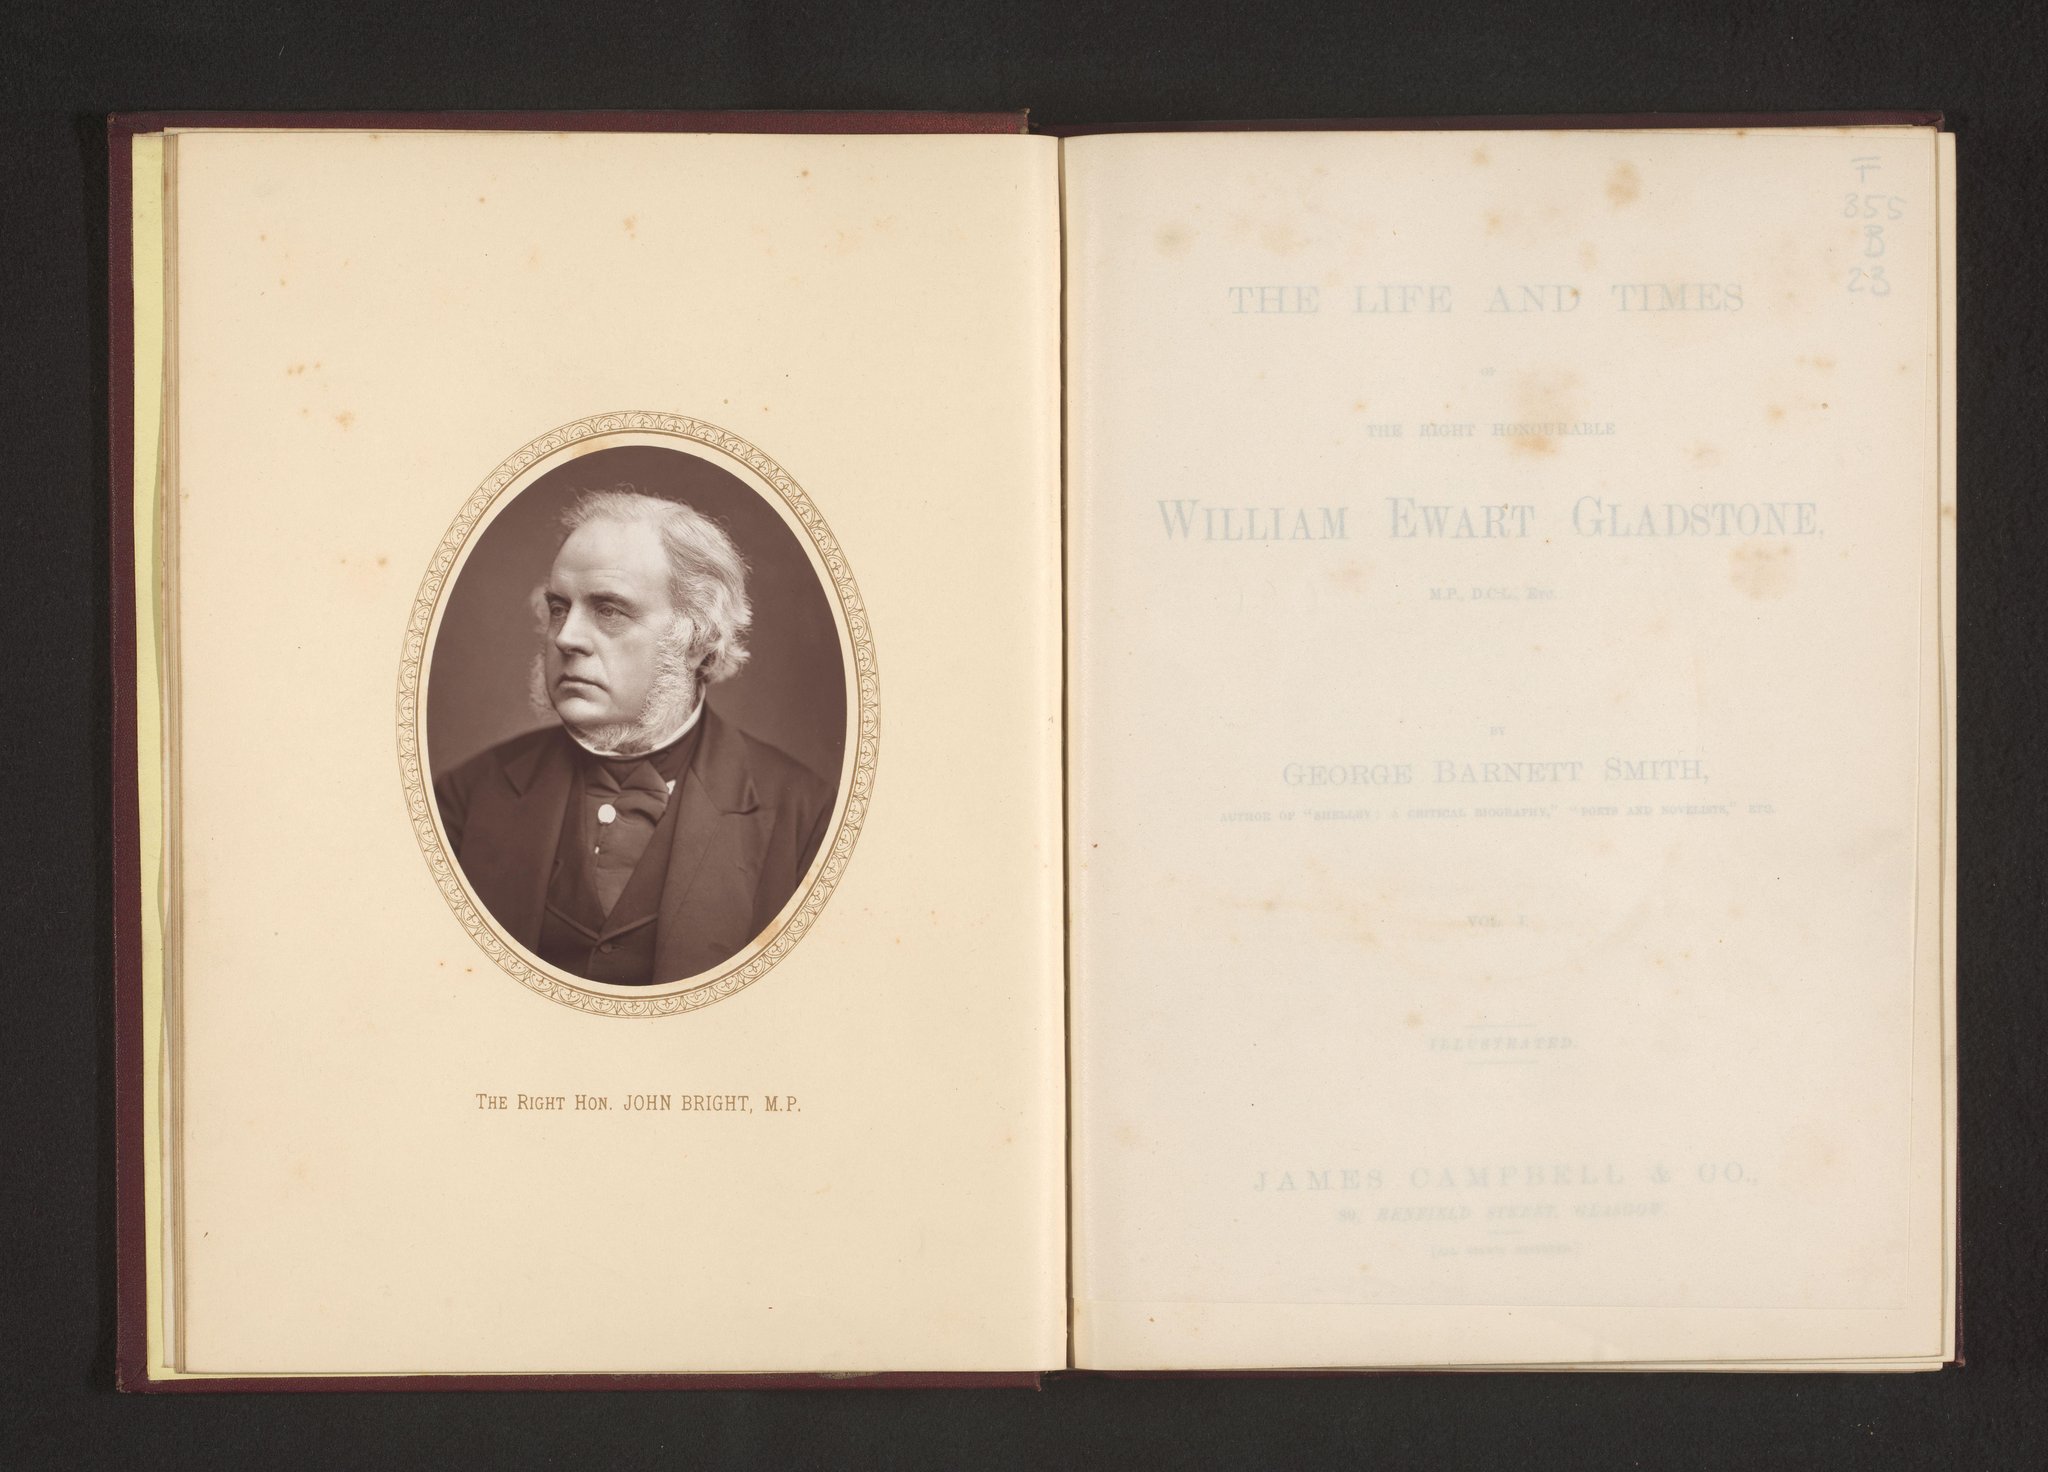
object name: photomechanical print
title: The right hon. John Bright, M.P.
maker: Anonymous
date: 1875-1880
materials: paper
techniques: woodburytype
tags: politician, e.g. party leader